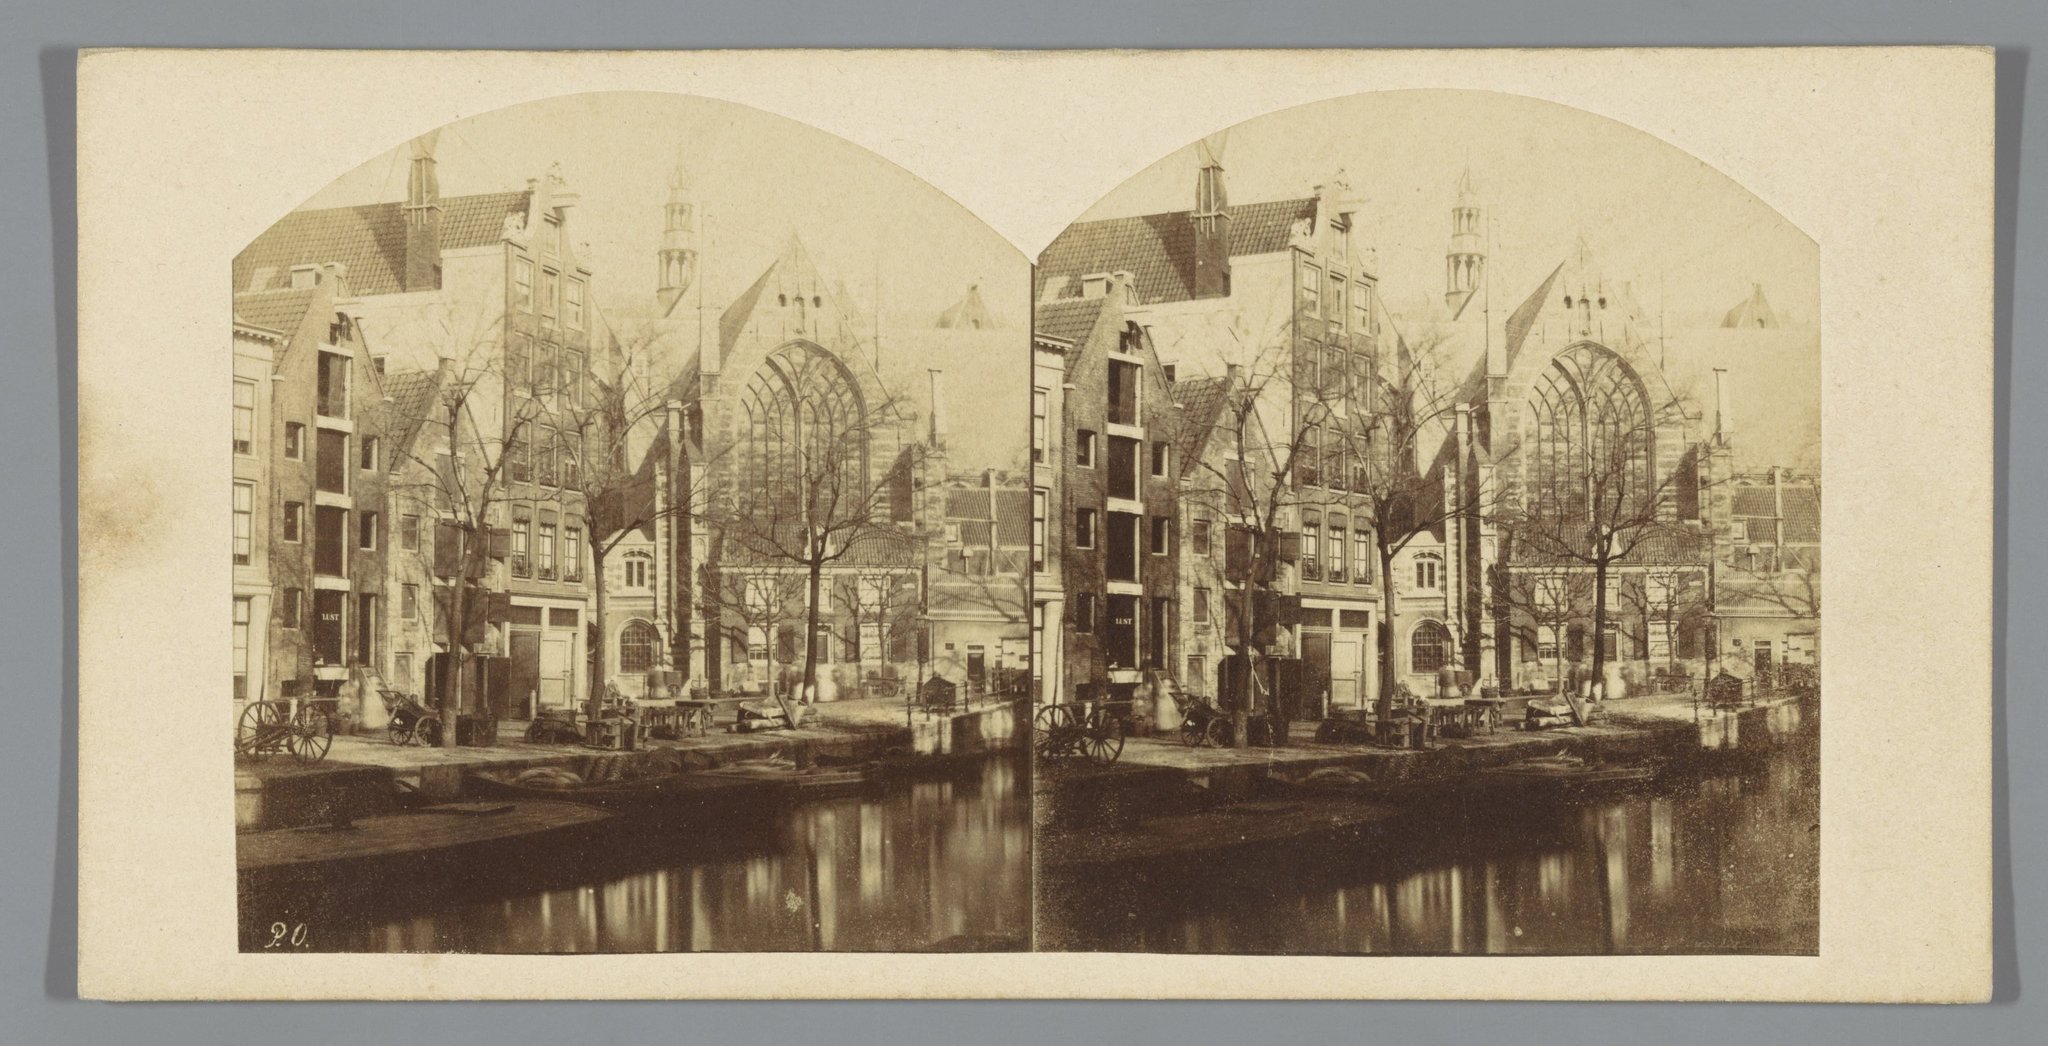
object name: stereograph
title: Oude Kerk, gezien vanaf de Oudezijds Voorburgwal, Amsterdam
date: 1859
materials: cardboard, paper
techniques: albumen print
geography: amsterdam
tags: church (exterior), canals, waters (in city)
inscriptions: inscription: ‘Gephotographiëerd in Maart 1859./ Uitgegeven door A. Jager, Water 110, te Amsterdam.’, initials: ‘P.O.’, number: ‘No. 16.’, inscription: ‘foto Pieter Oosterhuis’